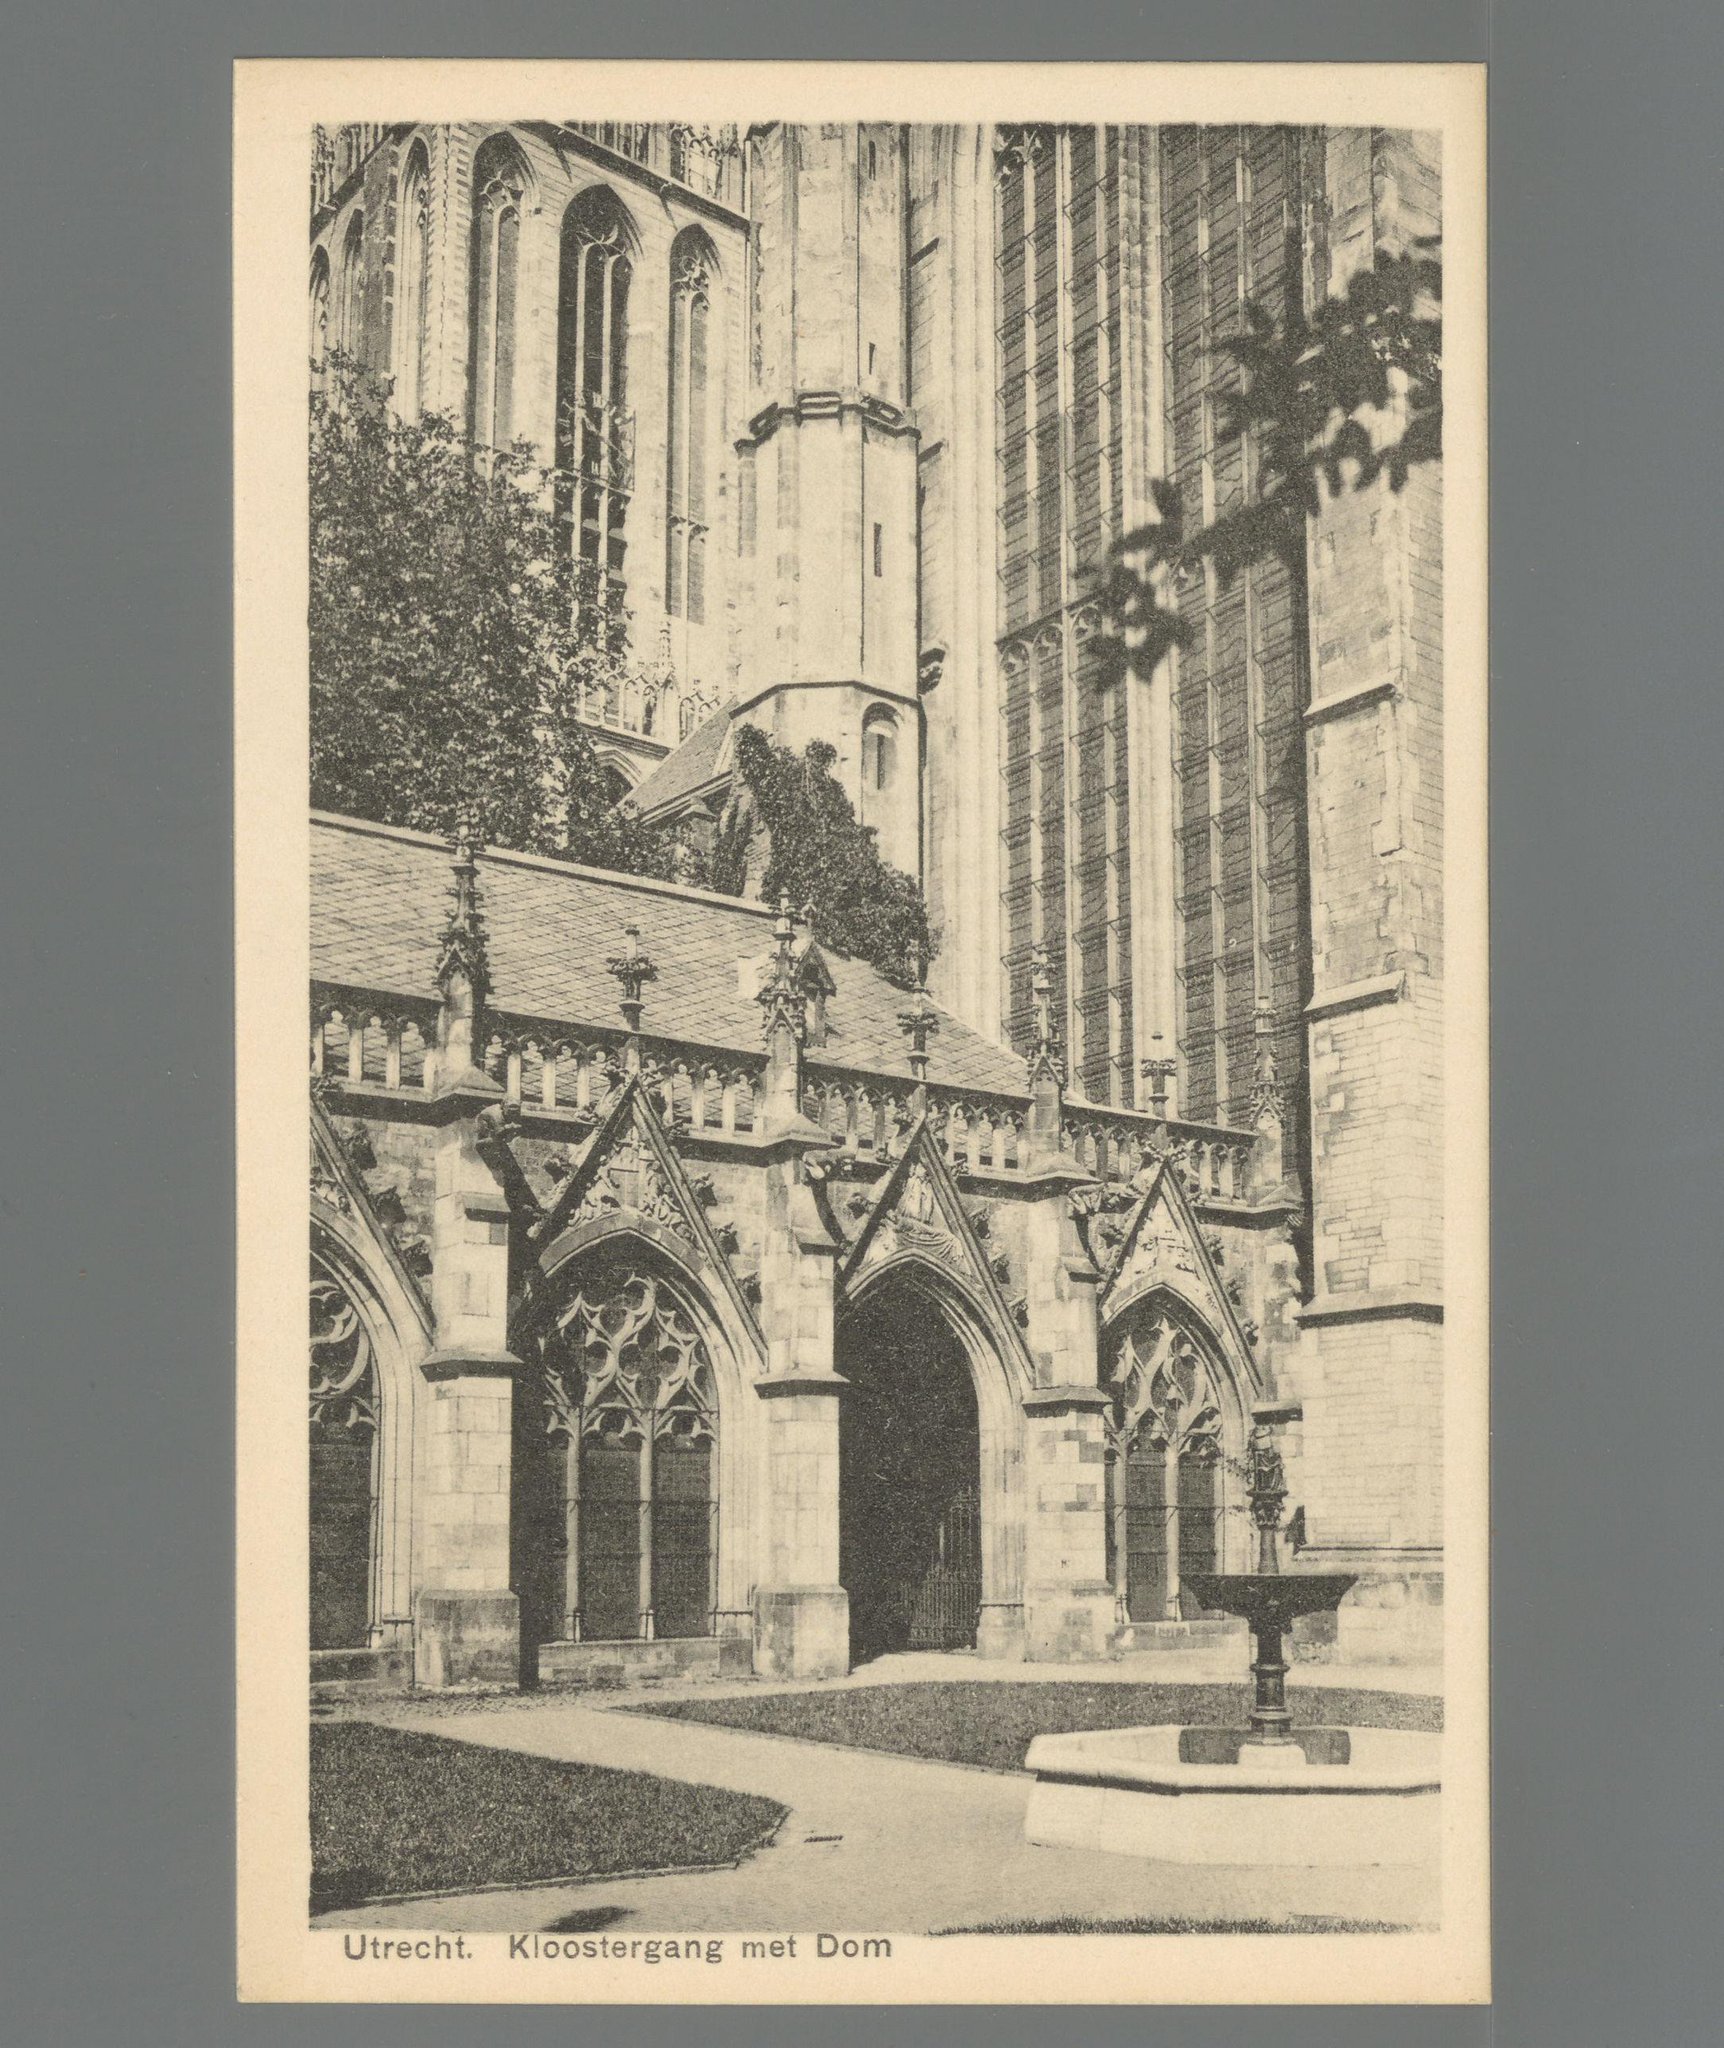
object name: photomechanical print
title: Utrecht. Kloostergang met Dom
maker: Anonymous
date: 1911-1930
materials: cardboard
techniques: photograph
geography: utrecht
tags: church (exterior), cloisters ~ monastery